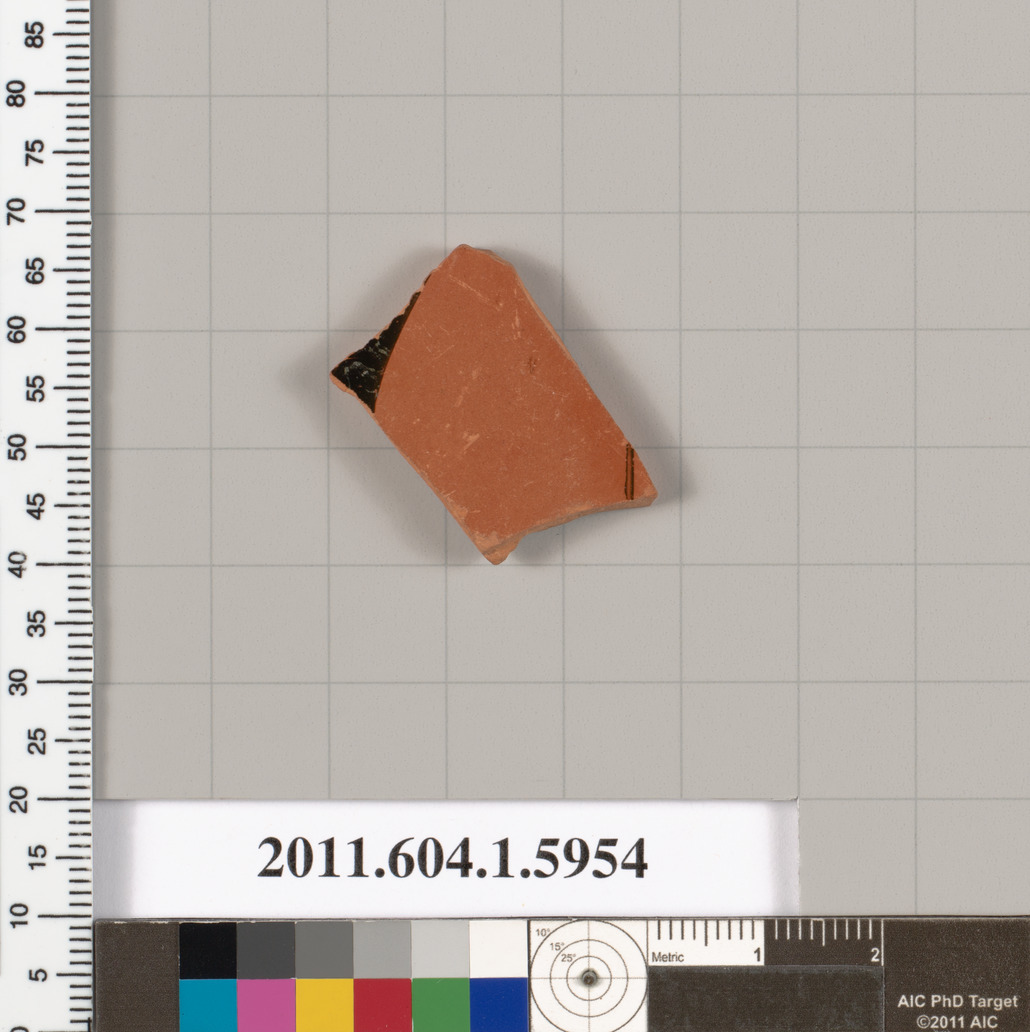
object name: kylix fragment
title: Terracotta fragment of a kylix (drinking cup)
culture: greek, attic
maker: skythes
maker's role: artist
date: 433-567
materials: terracotta